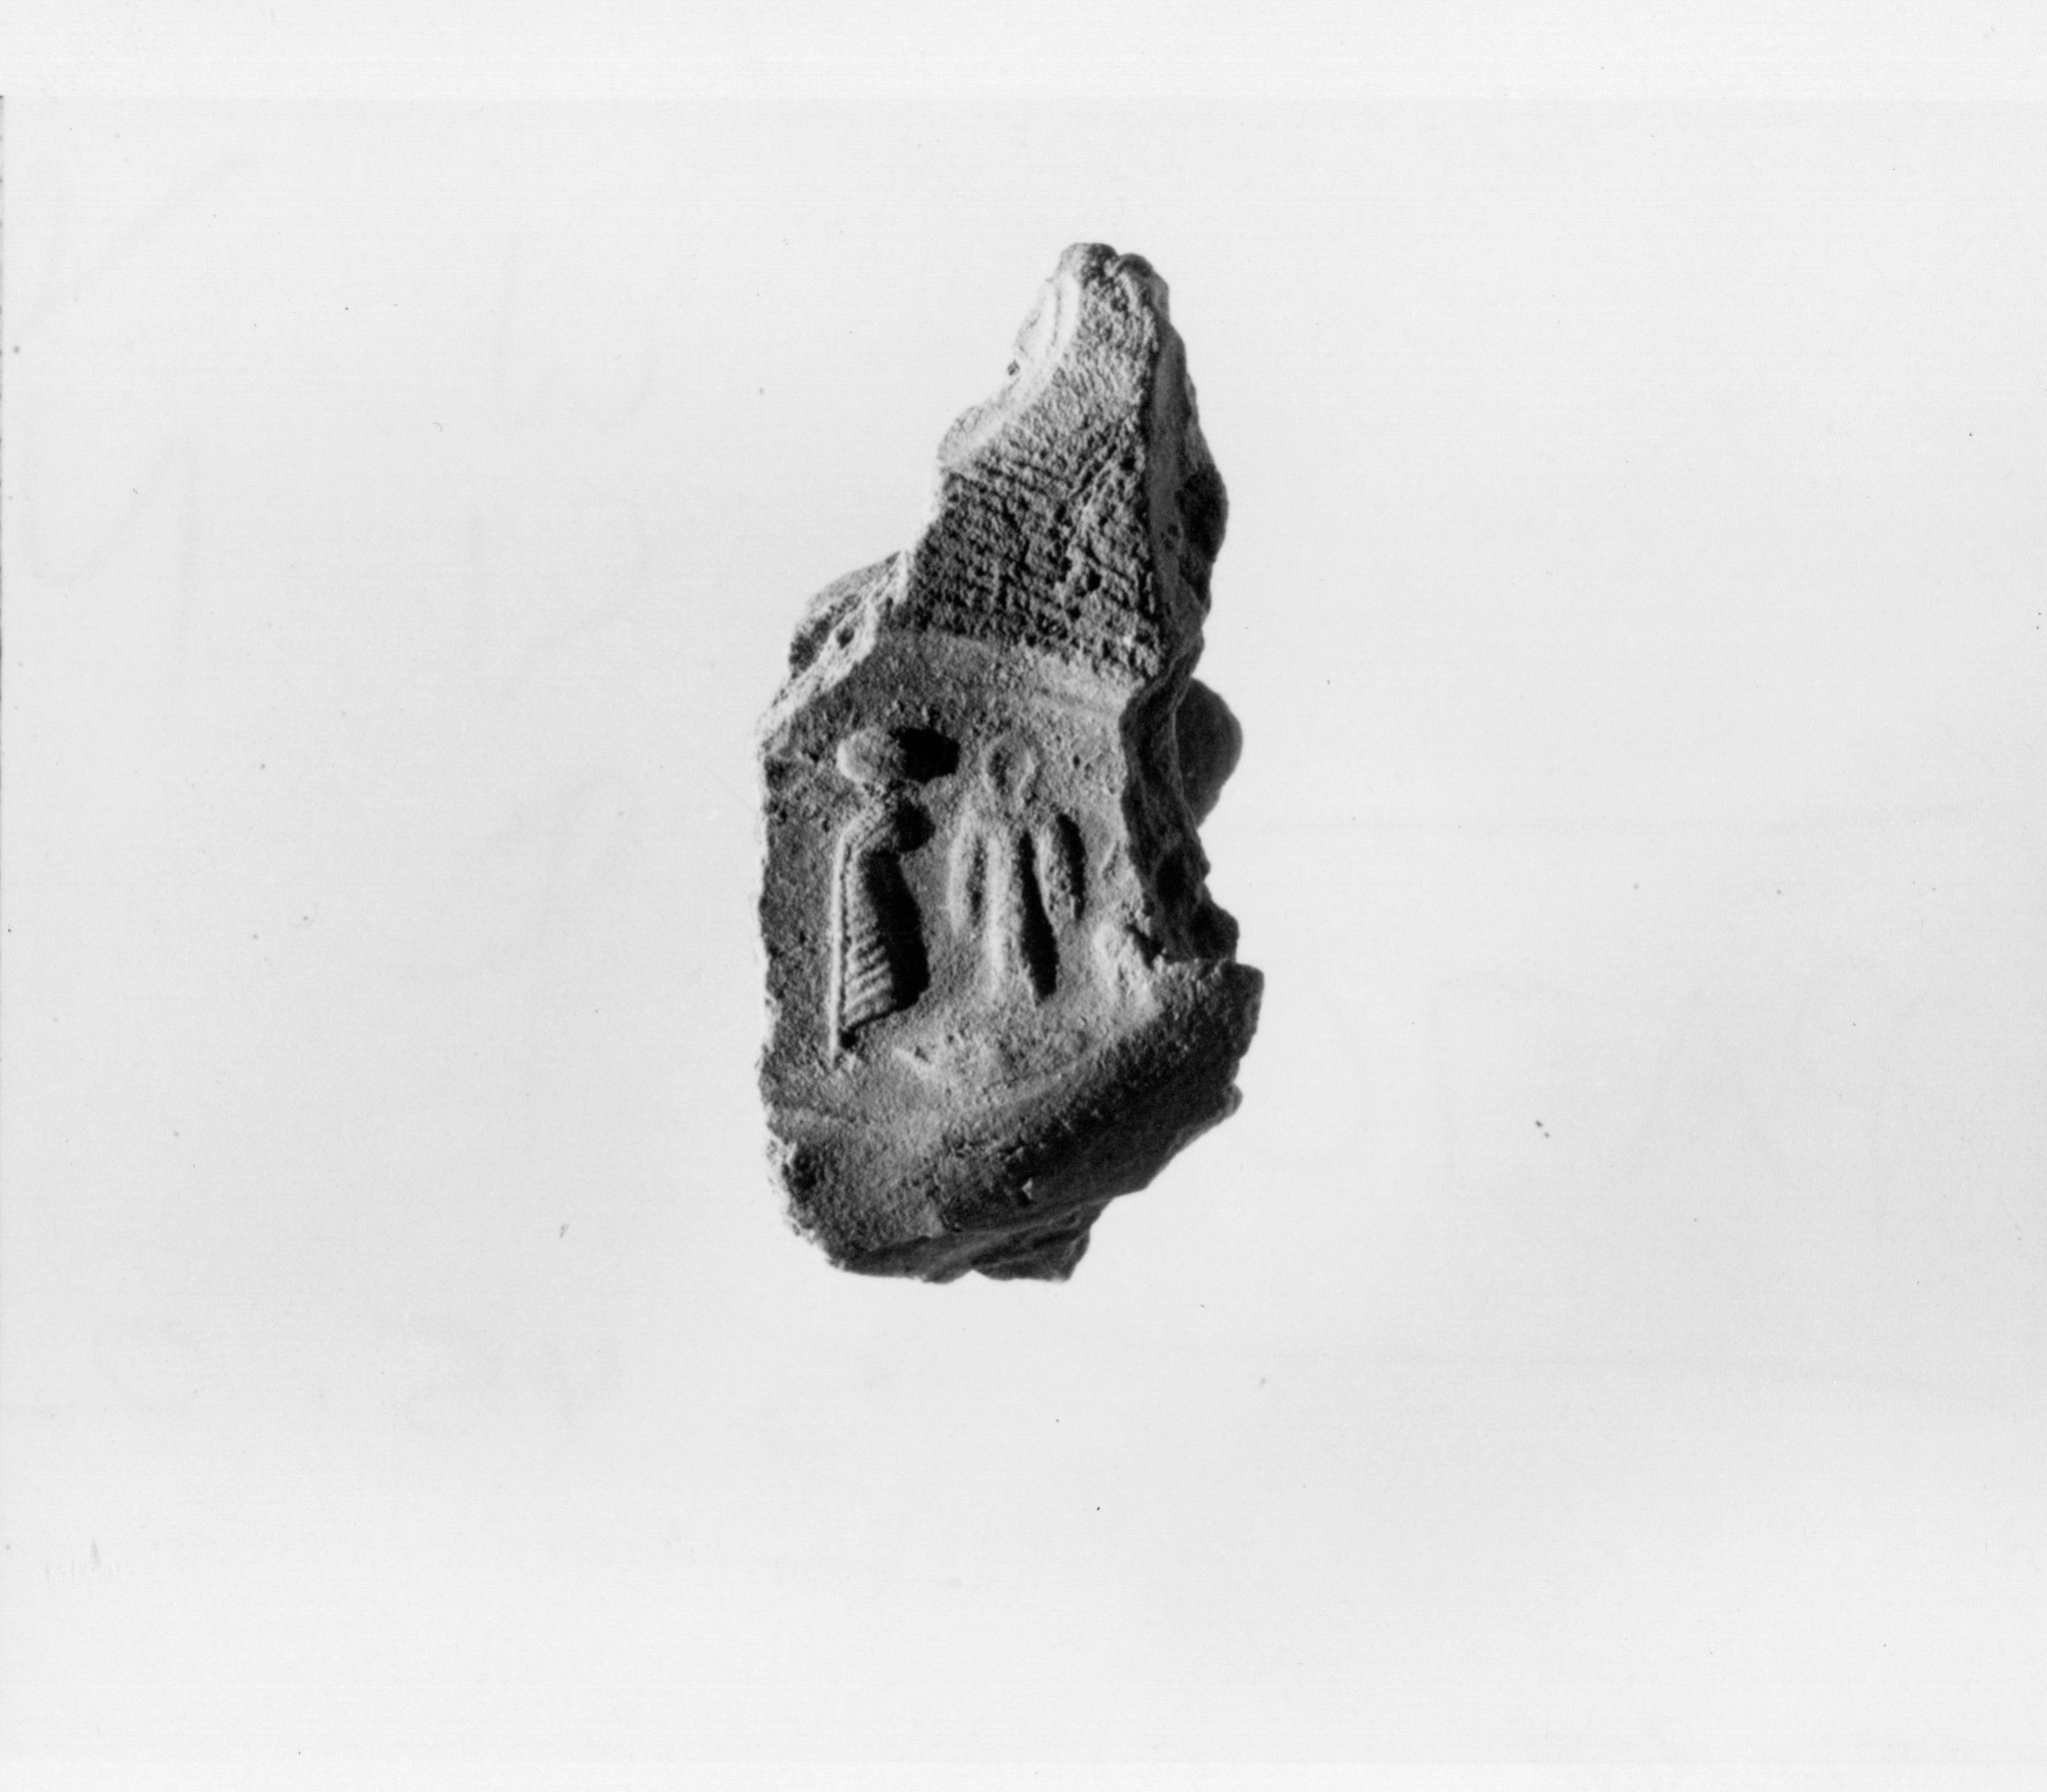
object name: sealing, nebmaatre, amenhotep iii, heb sed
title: Document Sealing With the Throne Name of Amenhotep III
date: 1390-1352 BCE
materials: mud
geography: egypt